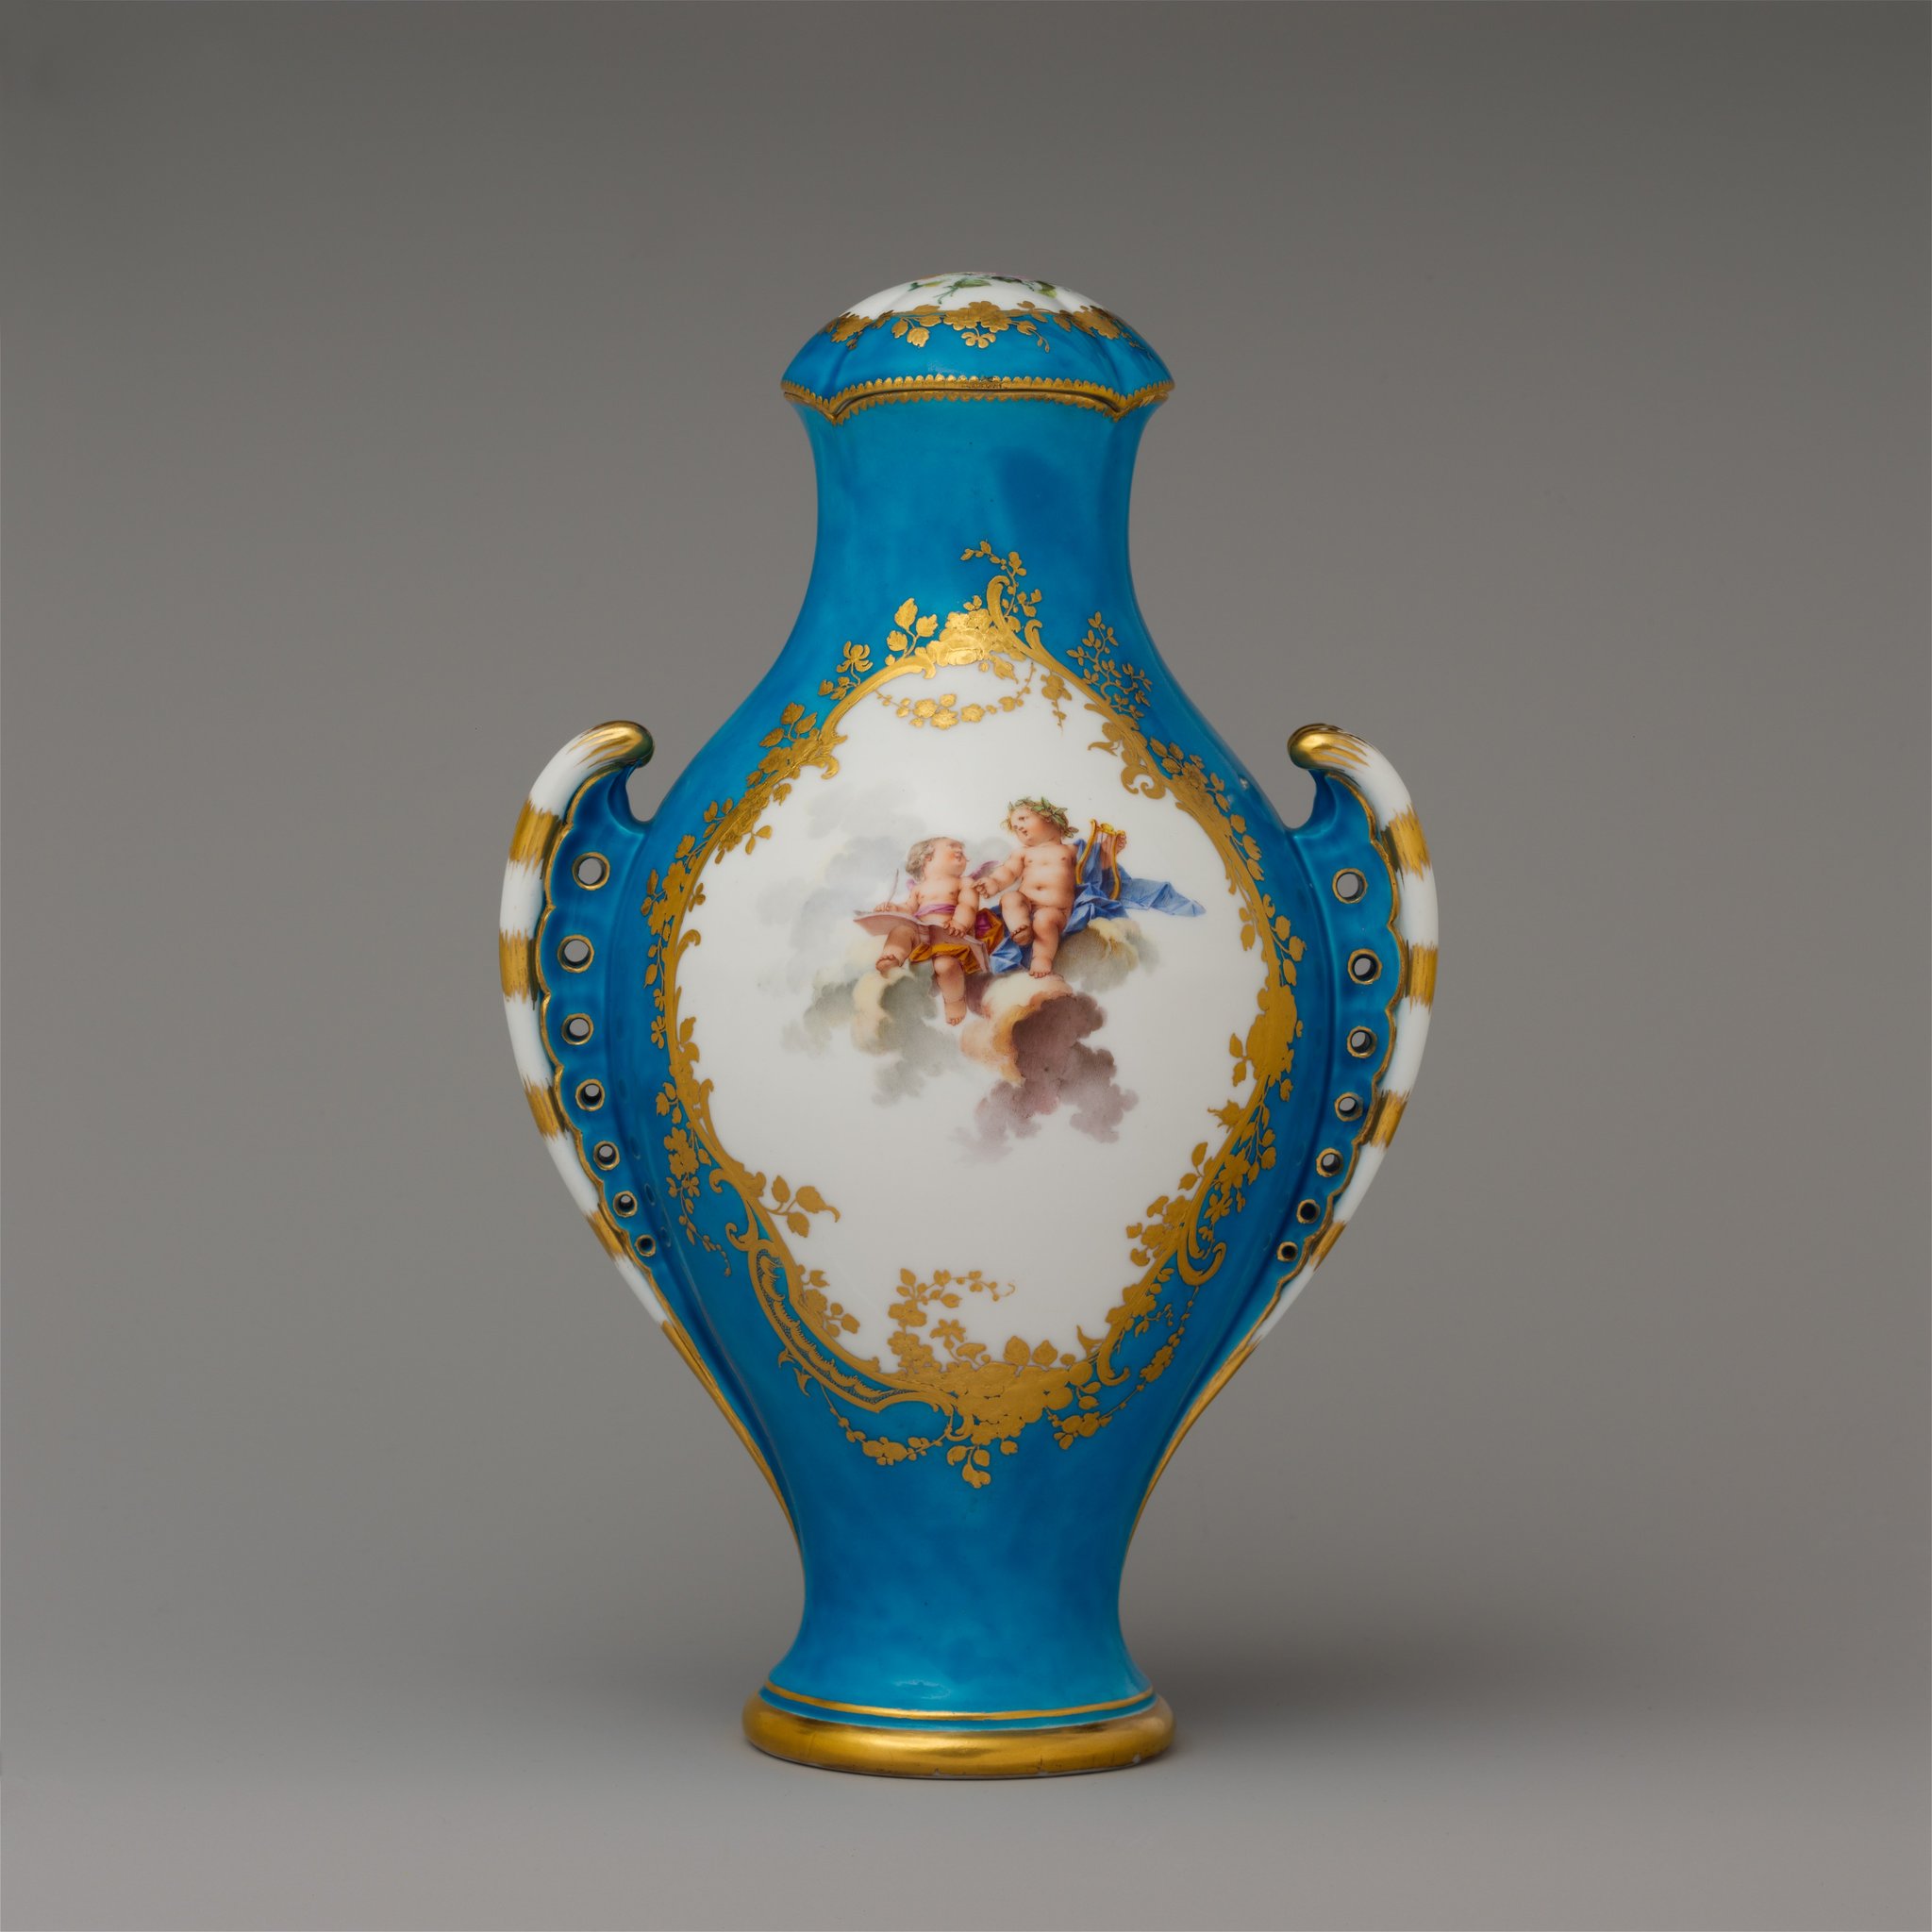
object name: vase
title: Vase with cover (vase urne antique)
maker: sèvres manufactory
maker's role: manufactory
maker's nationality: french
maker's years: 1740-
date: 1755-1757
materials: soft paste porcelain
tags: musical instruments,putti,writing